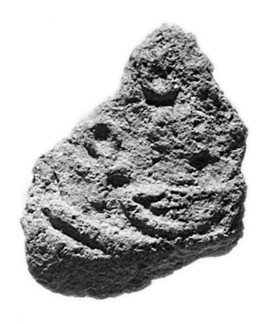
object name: sealing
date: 1981-1640 BCE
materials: mud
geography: egypt